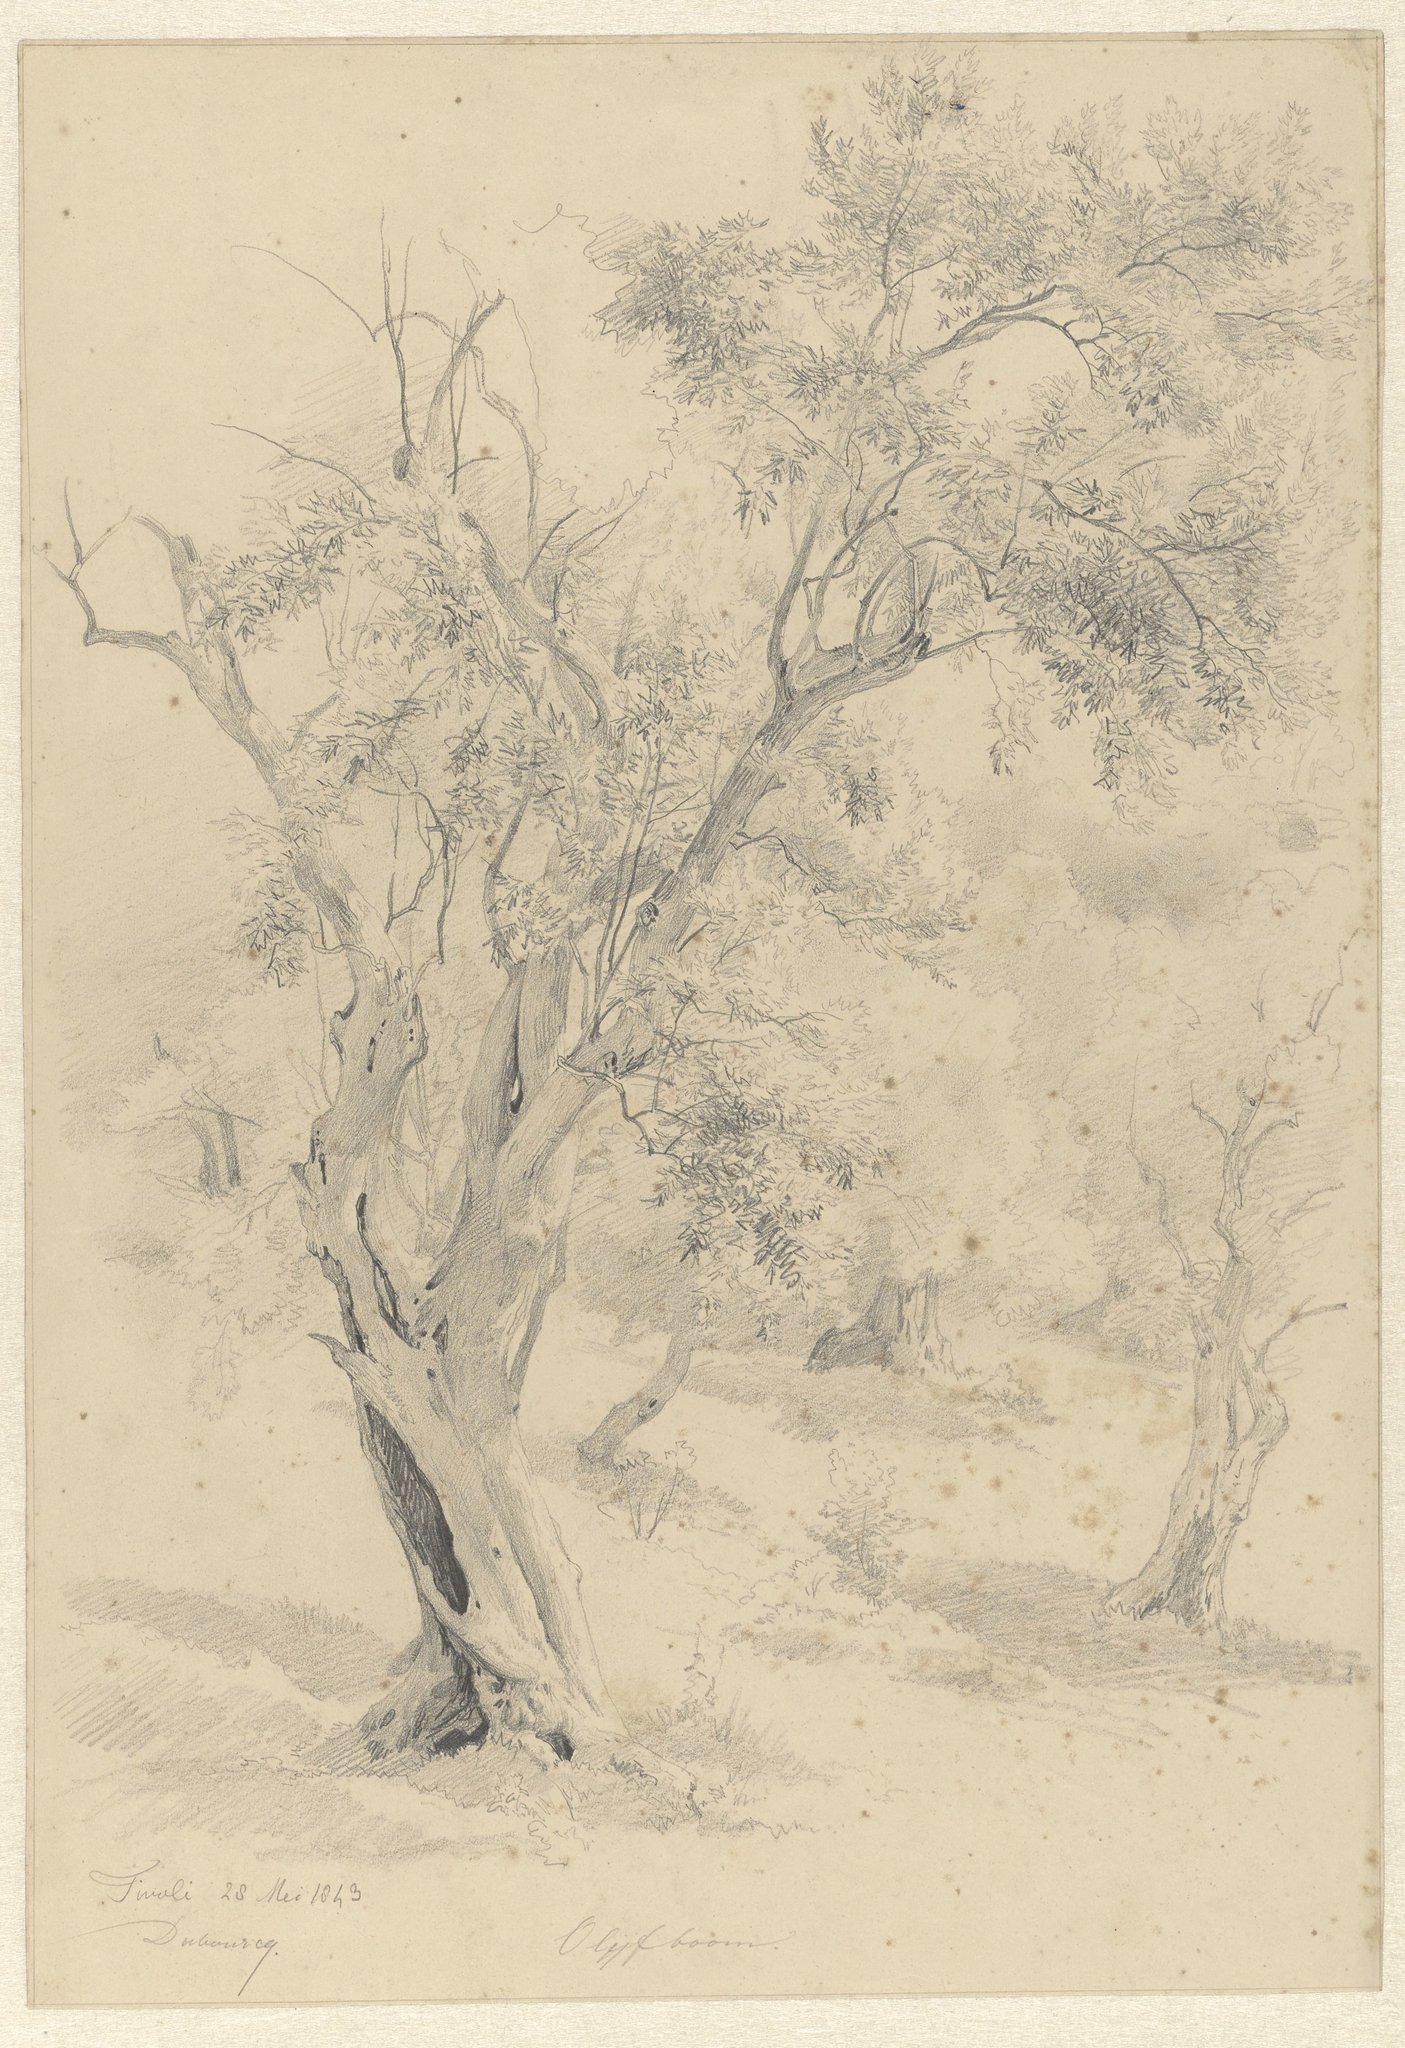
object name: drawing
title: Olijfboom, te Tivoli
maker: pierre louis dubourcq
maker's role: draughtsman, painter, print maker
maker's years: 1815-1873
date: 1843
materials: paper, pencil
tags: landscapes in the temperate zone, trees: olive-tree, italy, tivoli